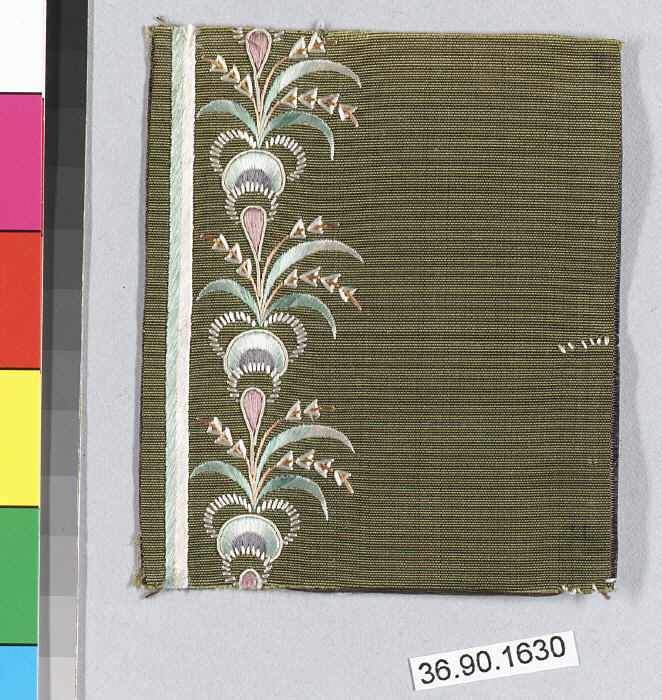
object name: sample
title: Embroidery sample for a man's suit or waistcoat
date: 1785-1815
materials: silk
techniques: embroidery